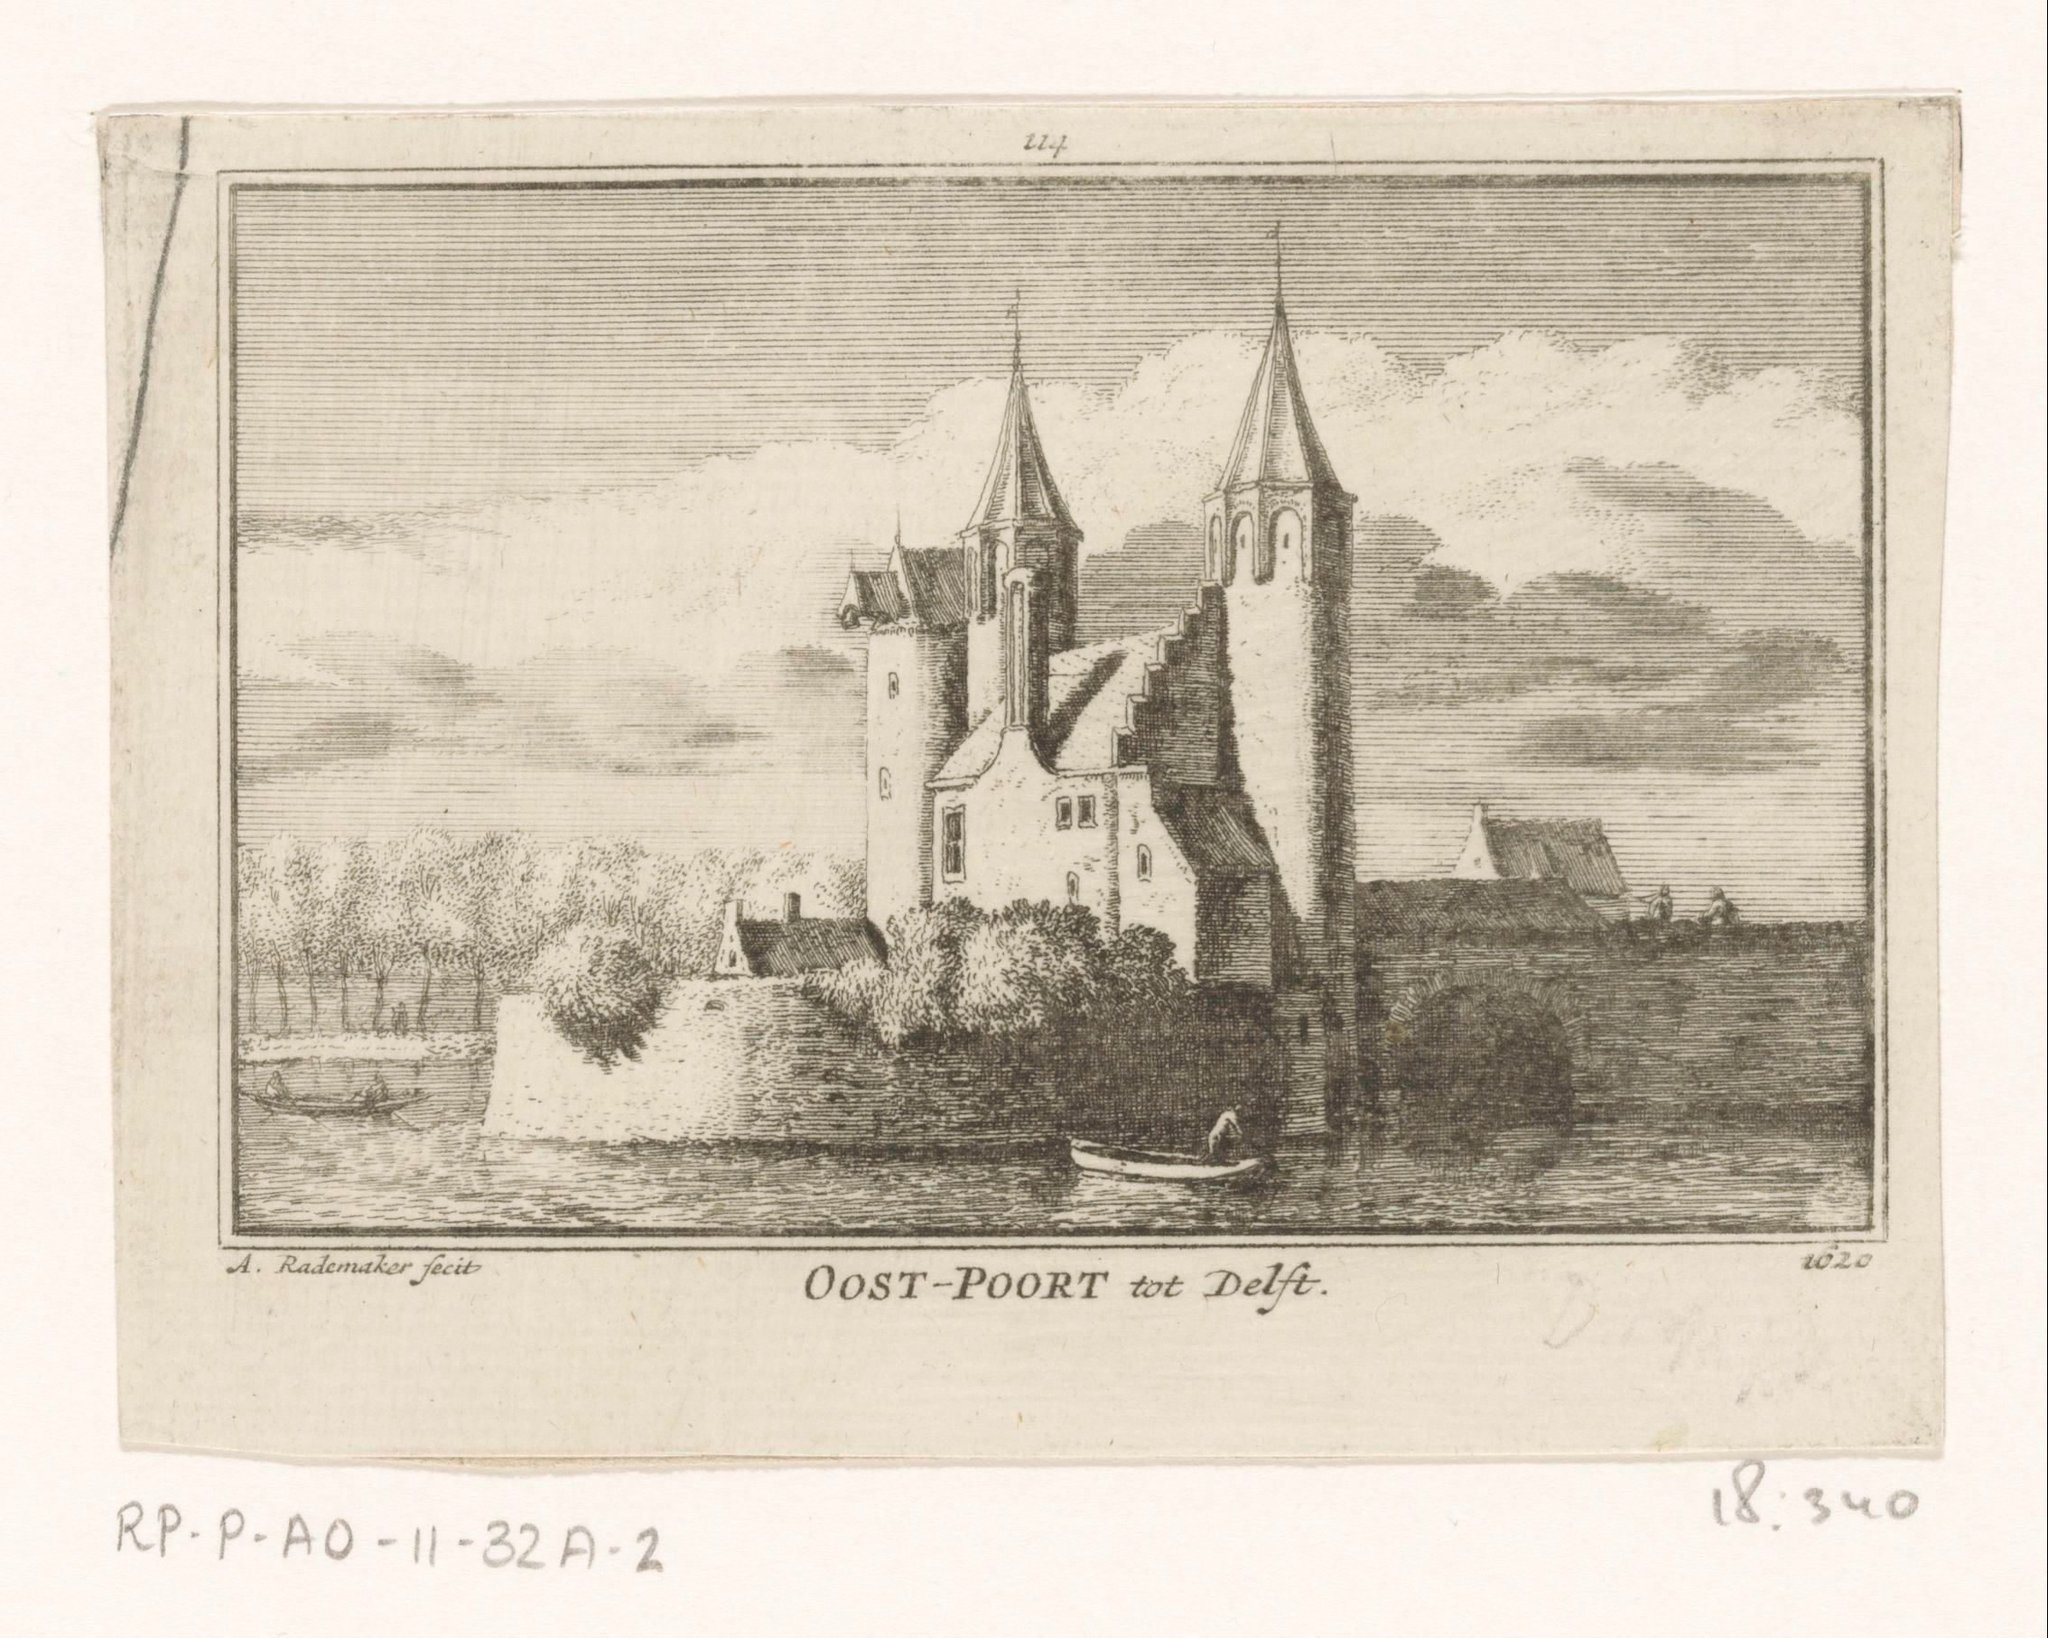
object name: print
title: Oost-Poort tot Delft 1620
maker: abraham rademaker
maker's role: draughtsman, print maker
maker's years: 1676-1735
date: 1725-1803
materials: paper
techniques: engraving, etching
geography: amsterdam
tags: rowing-boat, canoe, etc., city-gate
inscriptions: collector's mark: Lugt 2228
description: Prent ook gebruikt in: Rademaker, Abraham. Kabinet van Nederlandsche outheden en gezichten: vervat in 300 konstplaaten (…). 2 delen. Amsterdam: Willem Barents, 1725, dl. 1, ill. 114. Na 1725 is deze prent nog in verschillende heruitgaven verschenen, uitgegeven in 1727-1733, 1770-1771 en 1792-1803. Uit welke uitgave het huidige exemplaar precies komt is niet na te gaan.